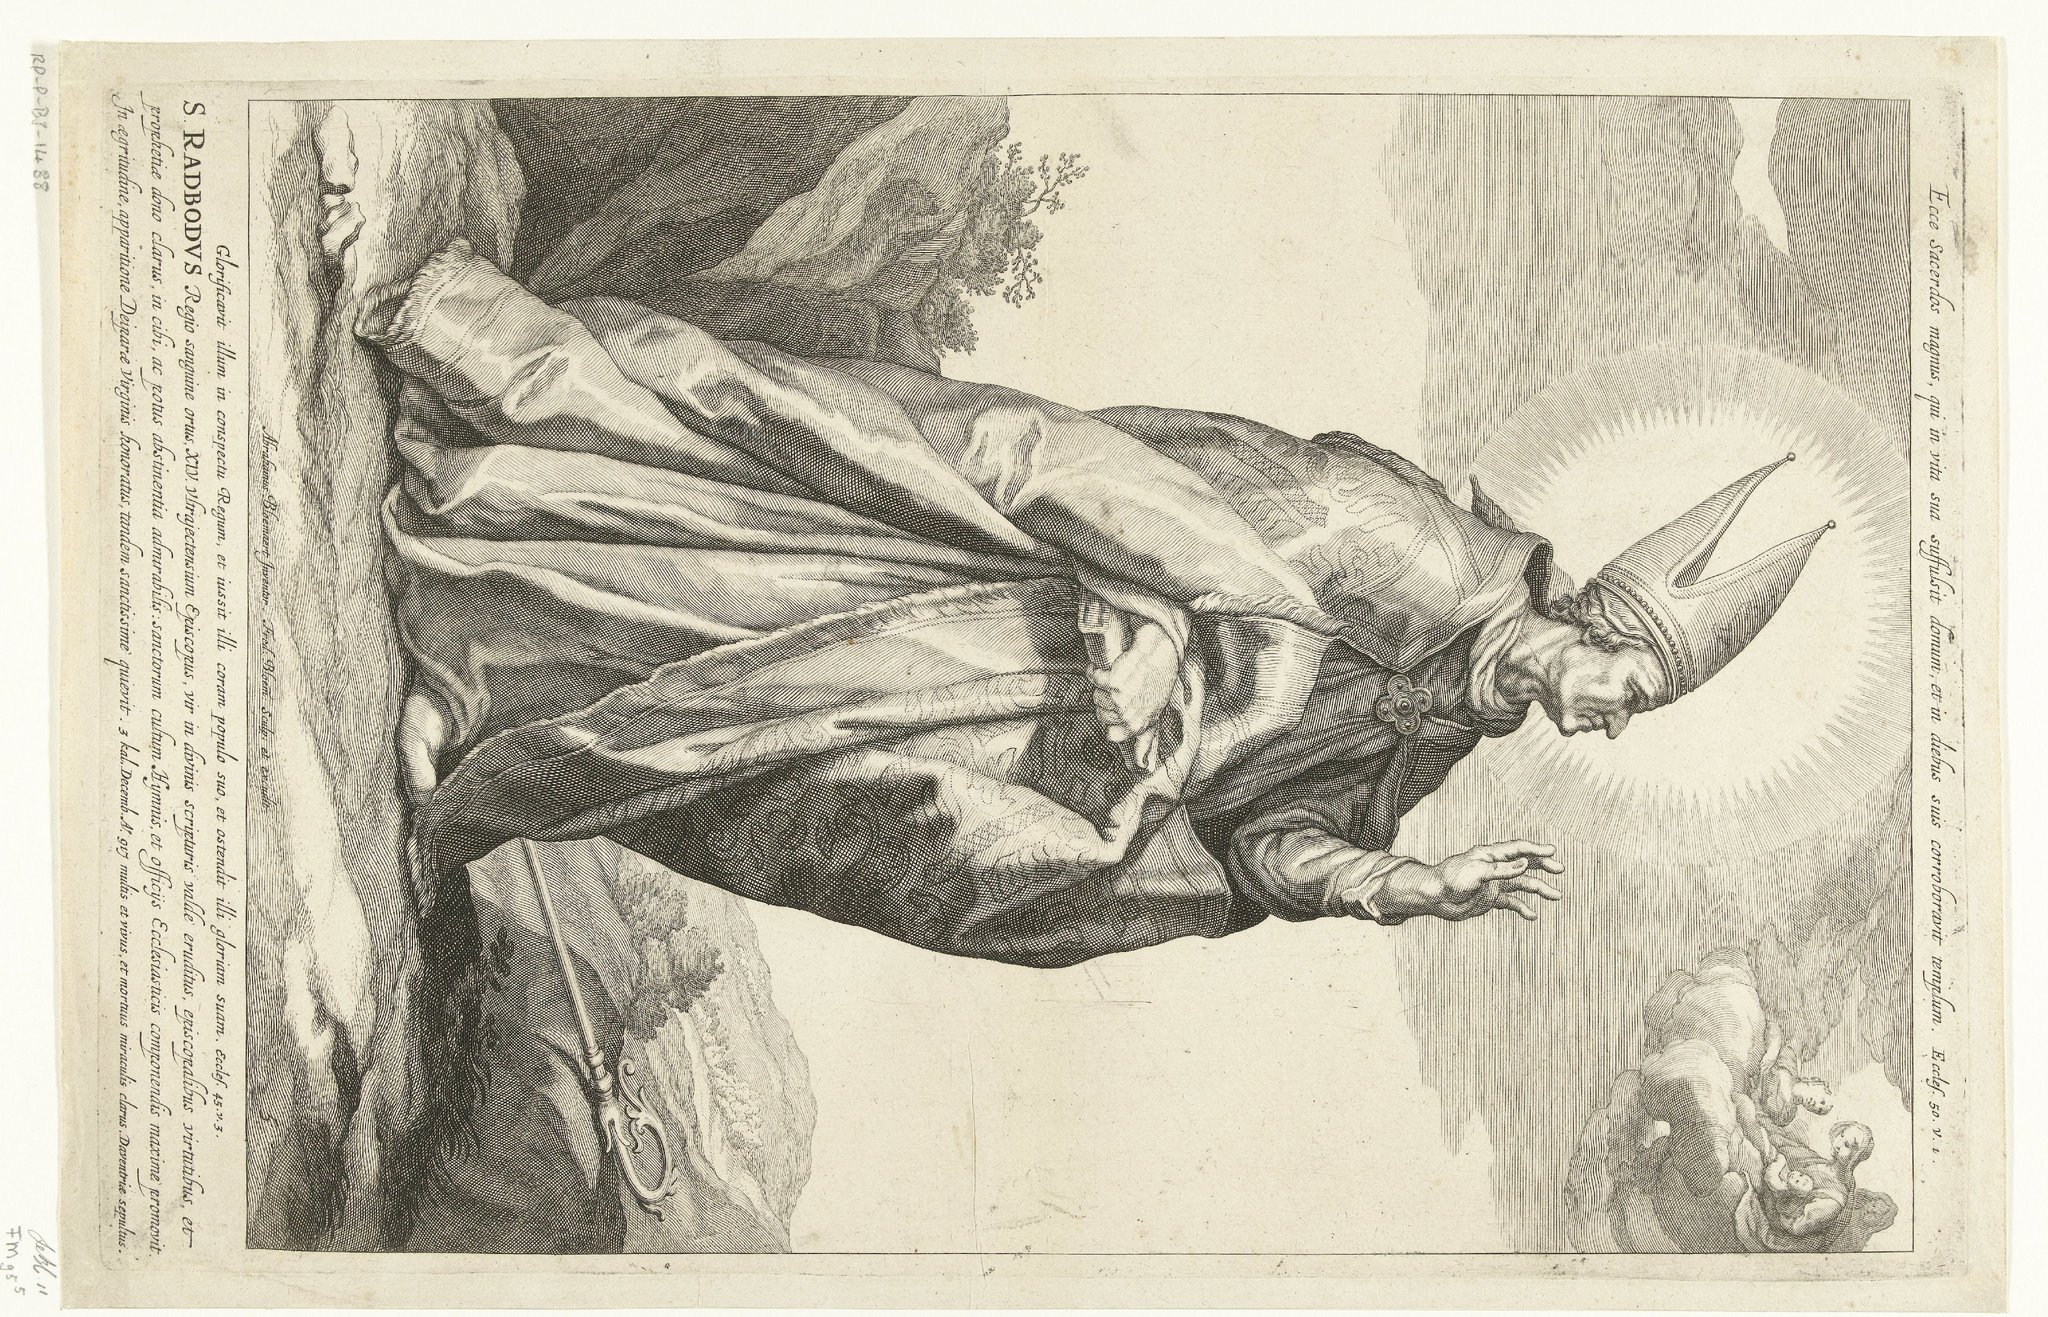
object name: print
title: Prelaten en bisschoppen van Utrecht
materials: paper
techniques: engraving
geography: utrecht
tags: radboud van utrecht, merovingische en karolingische tijd in nederland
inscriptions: collector's mark: Lugt 240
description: De heilige Radboud afgebeeld als een bisschop met tuniek, kap, mijter en kruis op het moment dat hij het visioen ondergaat van Madonna met het Kind met de heiligen Agnes en Thecla. Met een verklarend Latijns onderschrift. Prent uit een serie van twaalf prenten met prelaten en bisschoppen van Utrecht door Cornelis en Frederick Bloemaert.